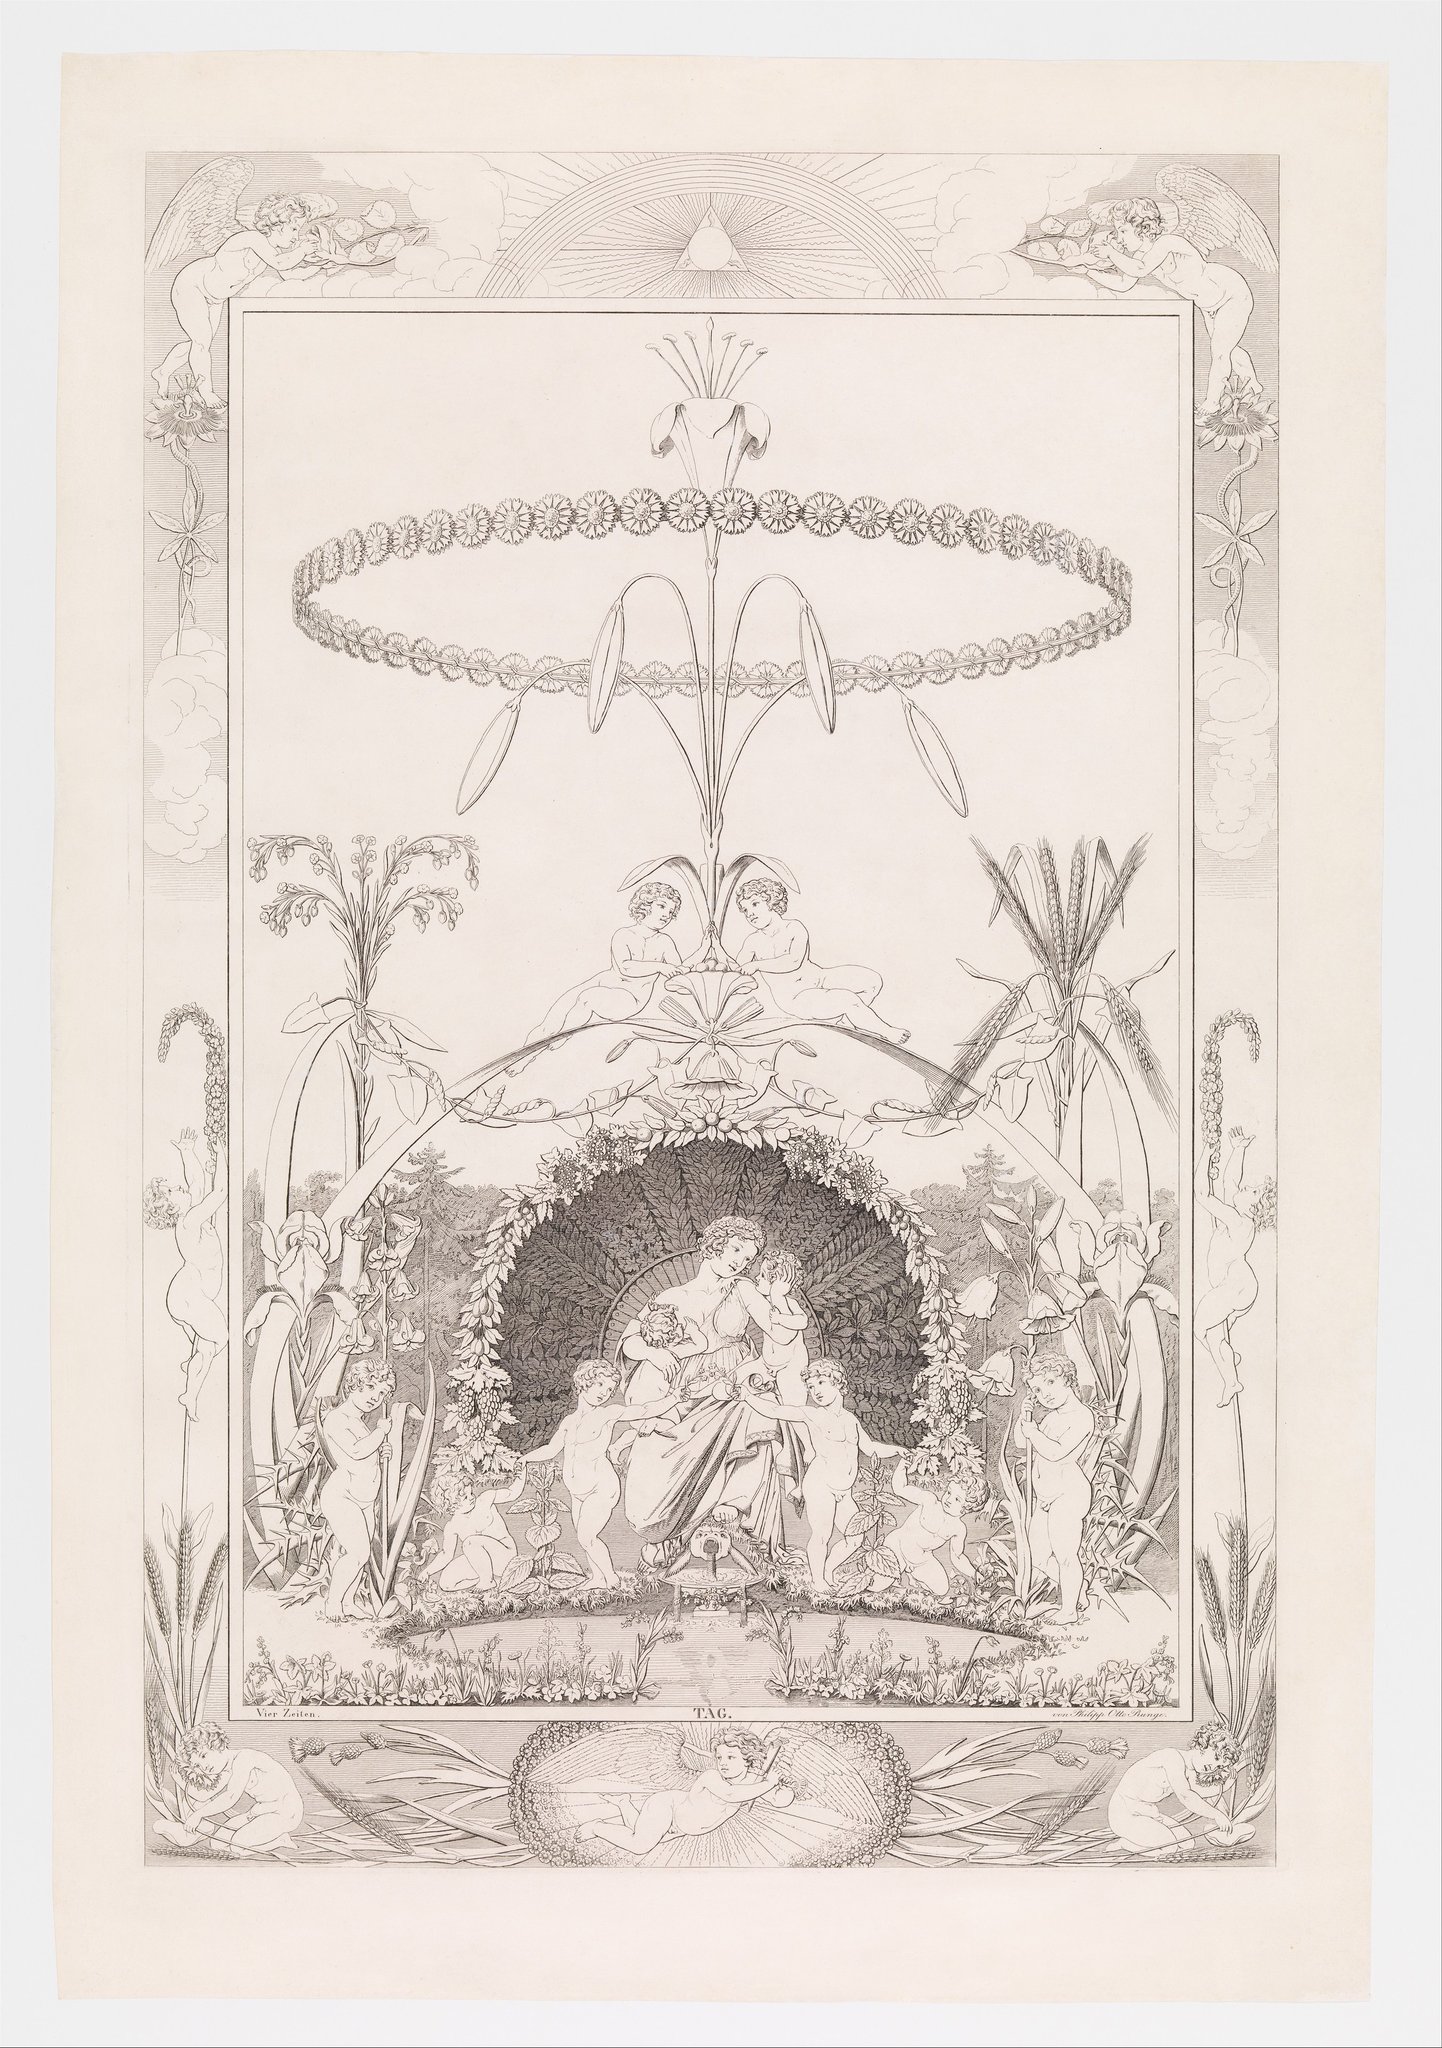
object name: print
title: Day, from the series The Times of the Day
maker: philipp otto runge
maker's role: artist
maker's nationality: german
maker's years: 1777-1810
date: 1807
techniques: engraving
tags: children,women